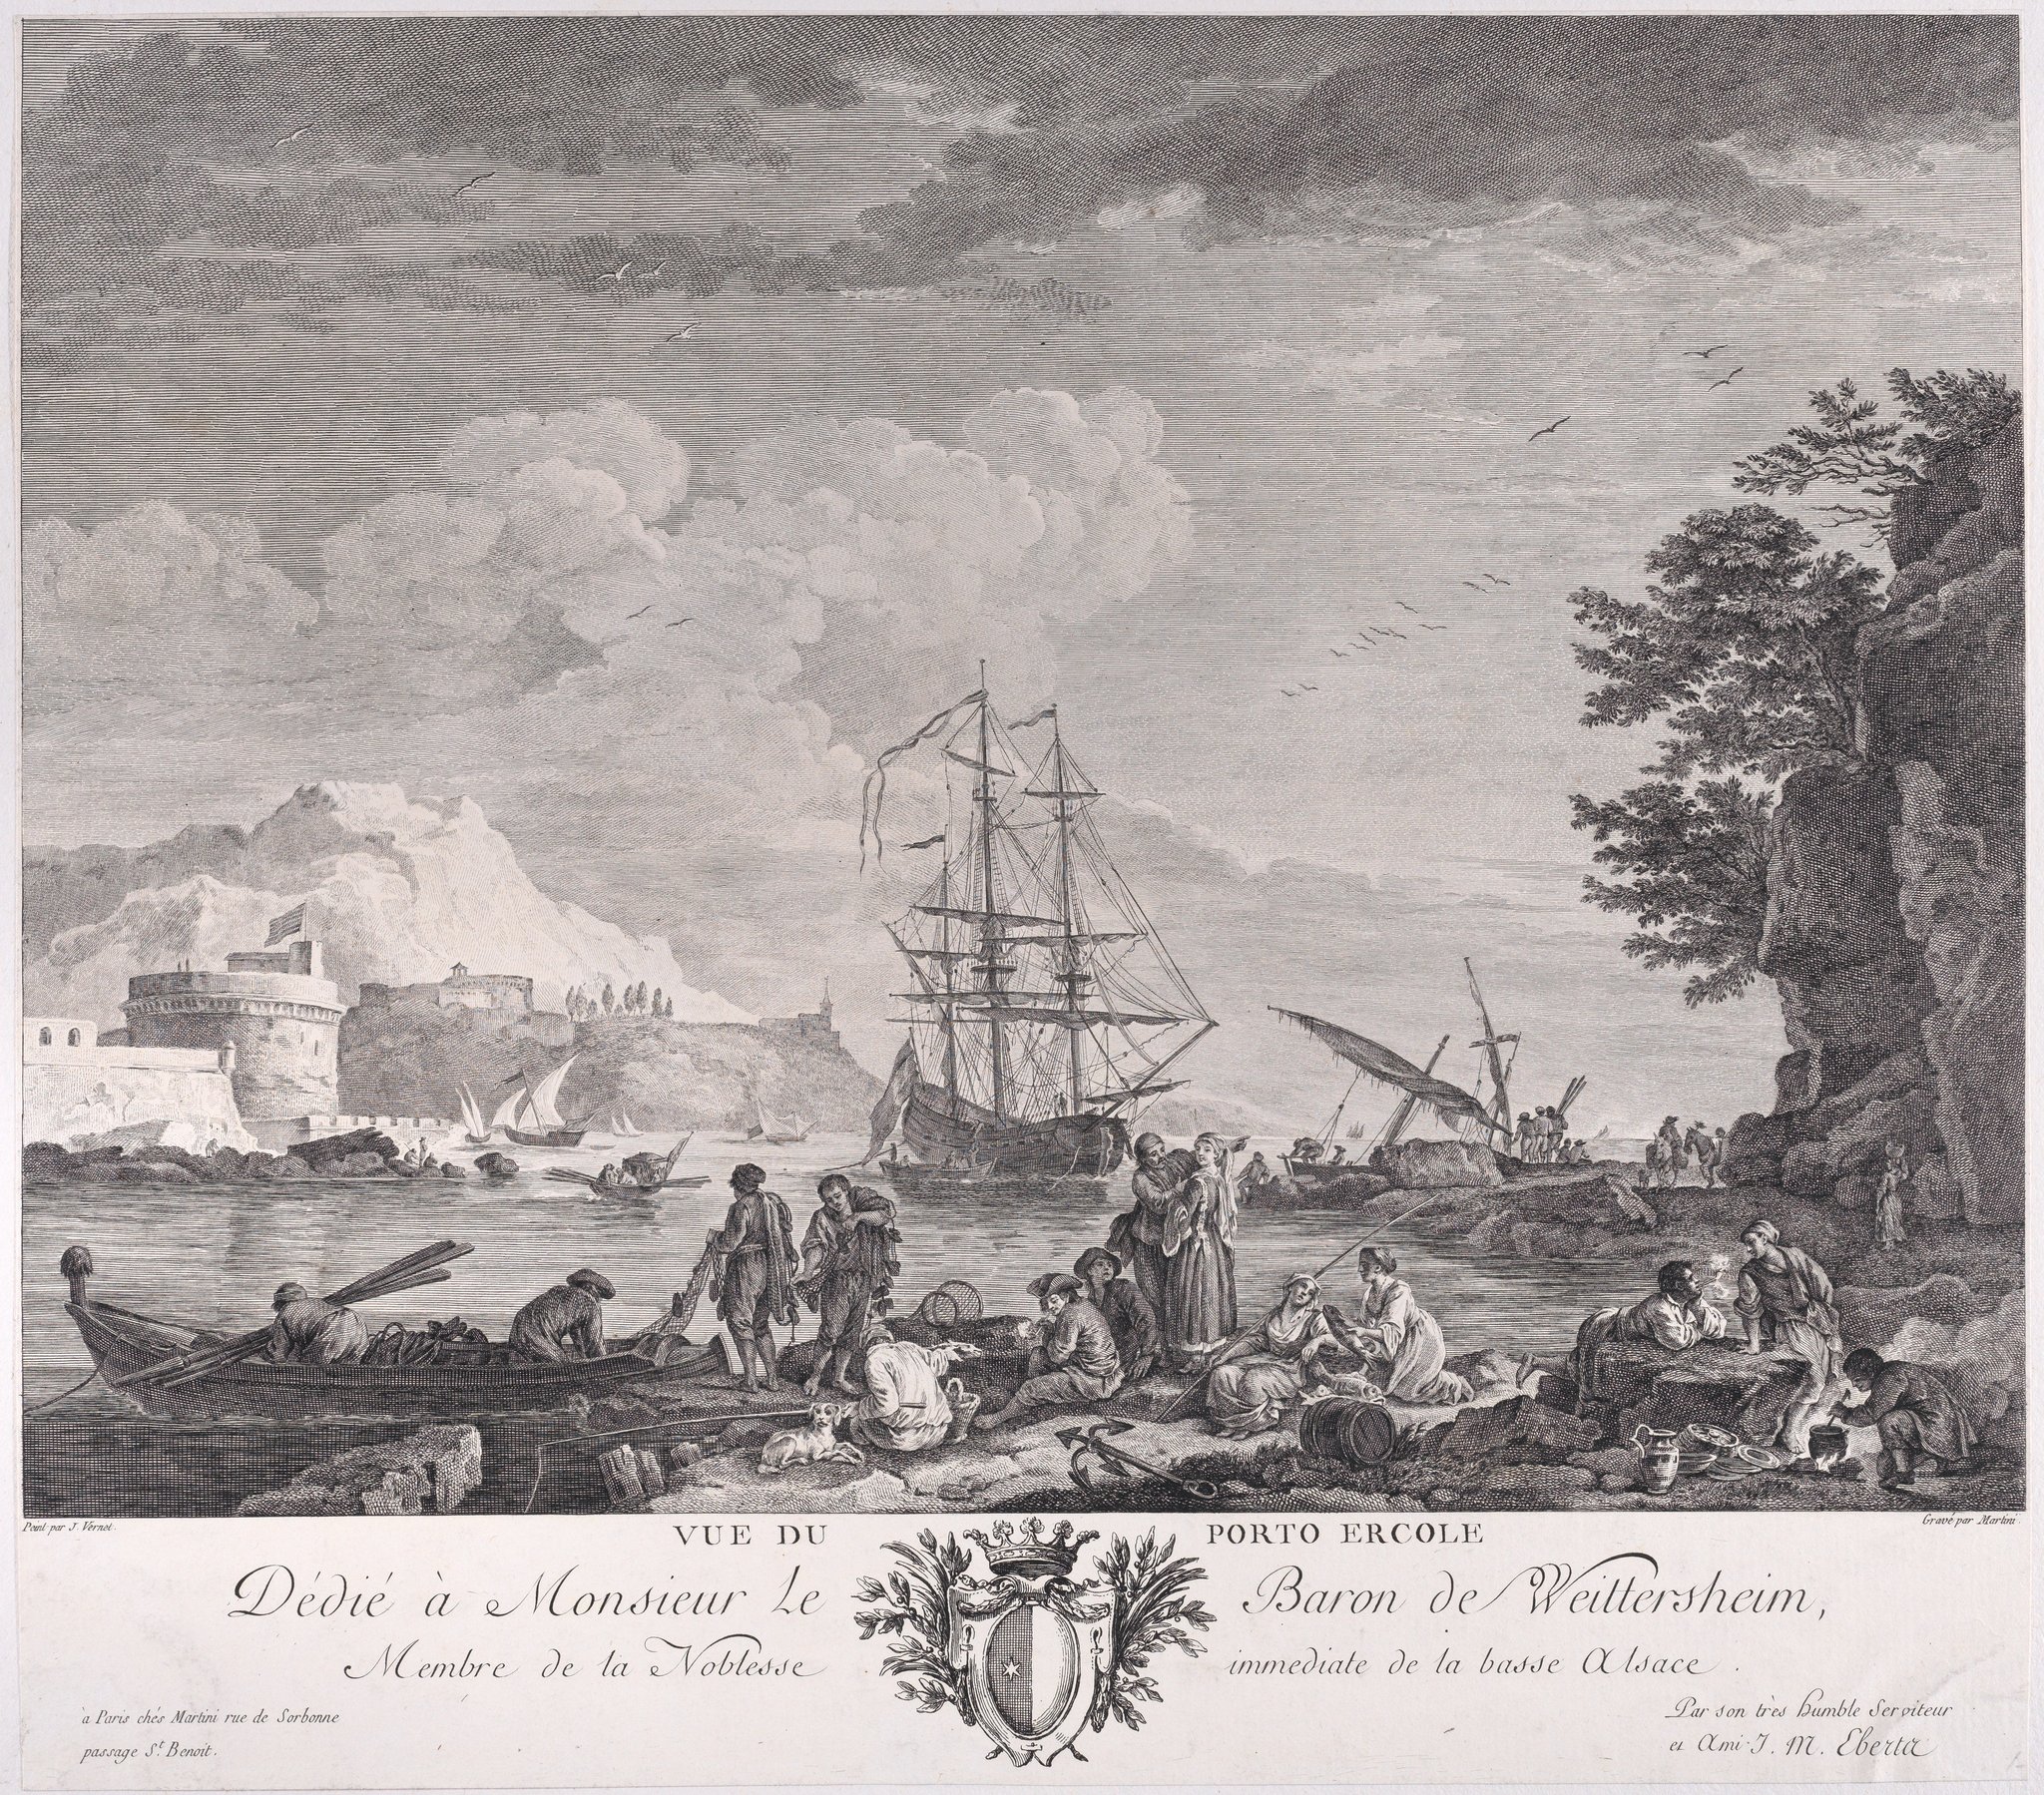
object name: print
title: View of Port Ercole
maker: joseph vernet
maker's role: artist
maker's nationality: french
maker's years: 1714-1789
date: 1750-1800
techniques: engraving